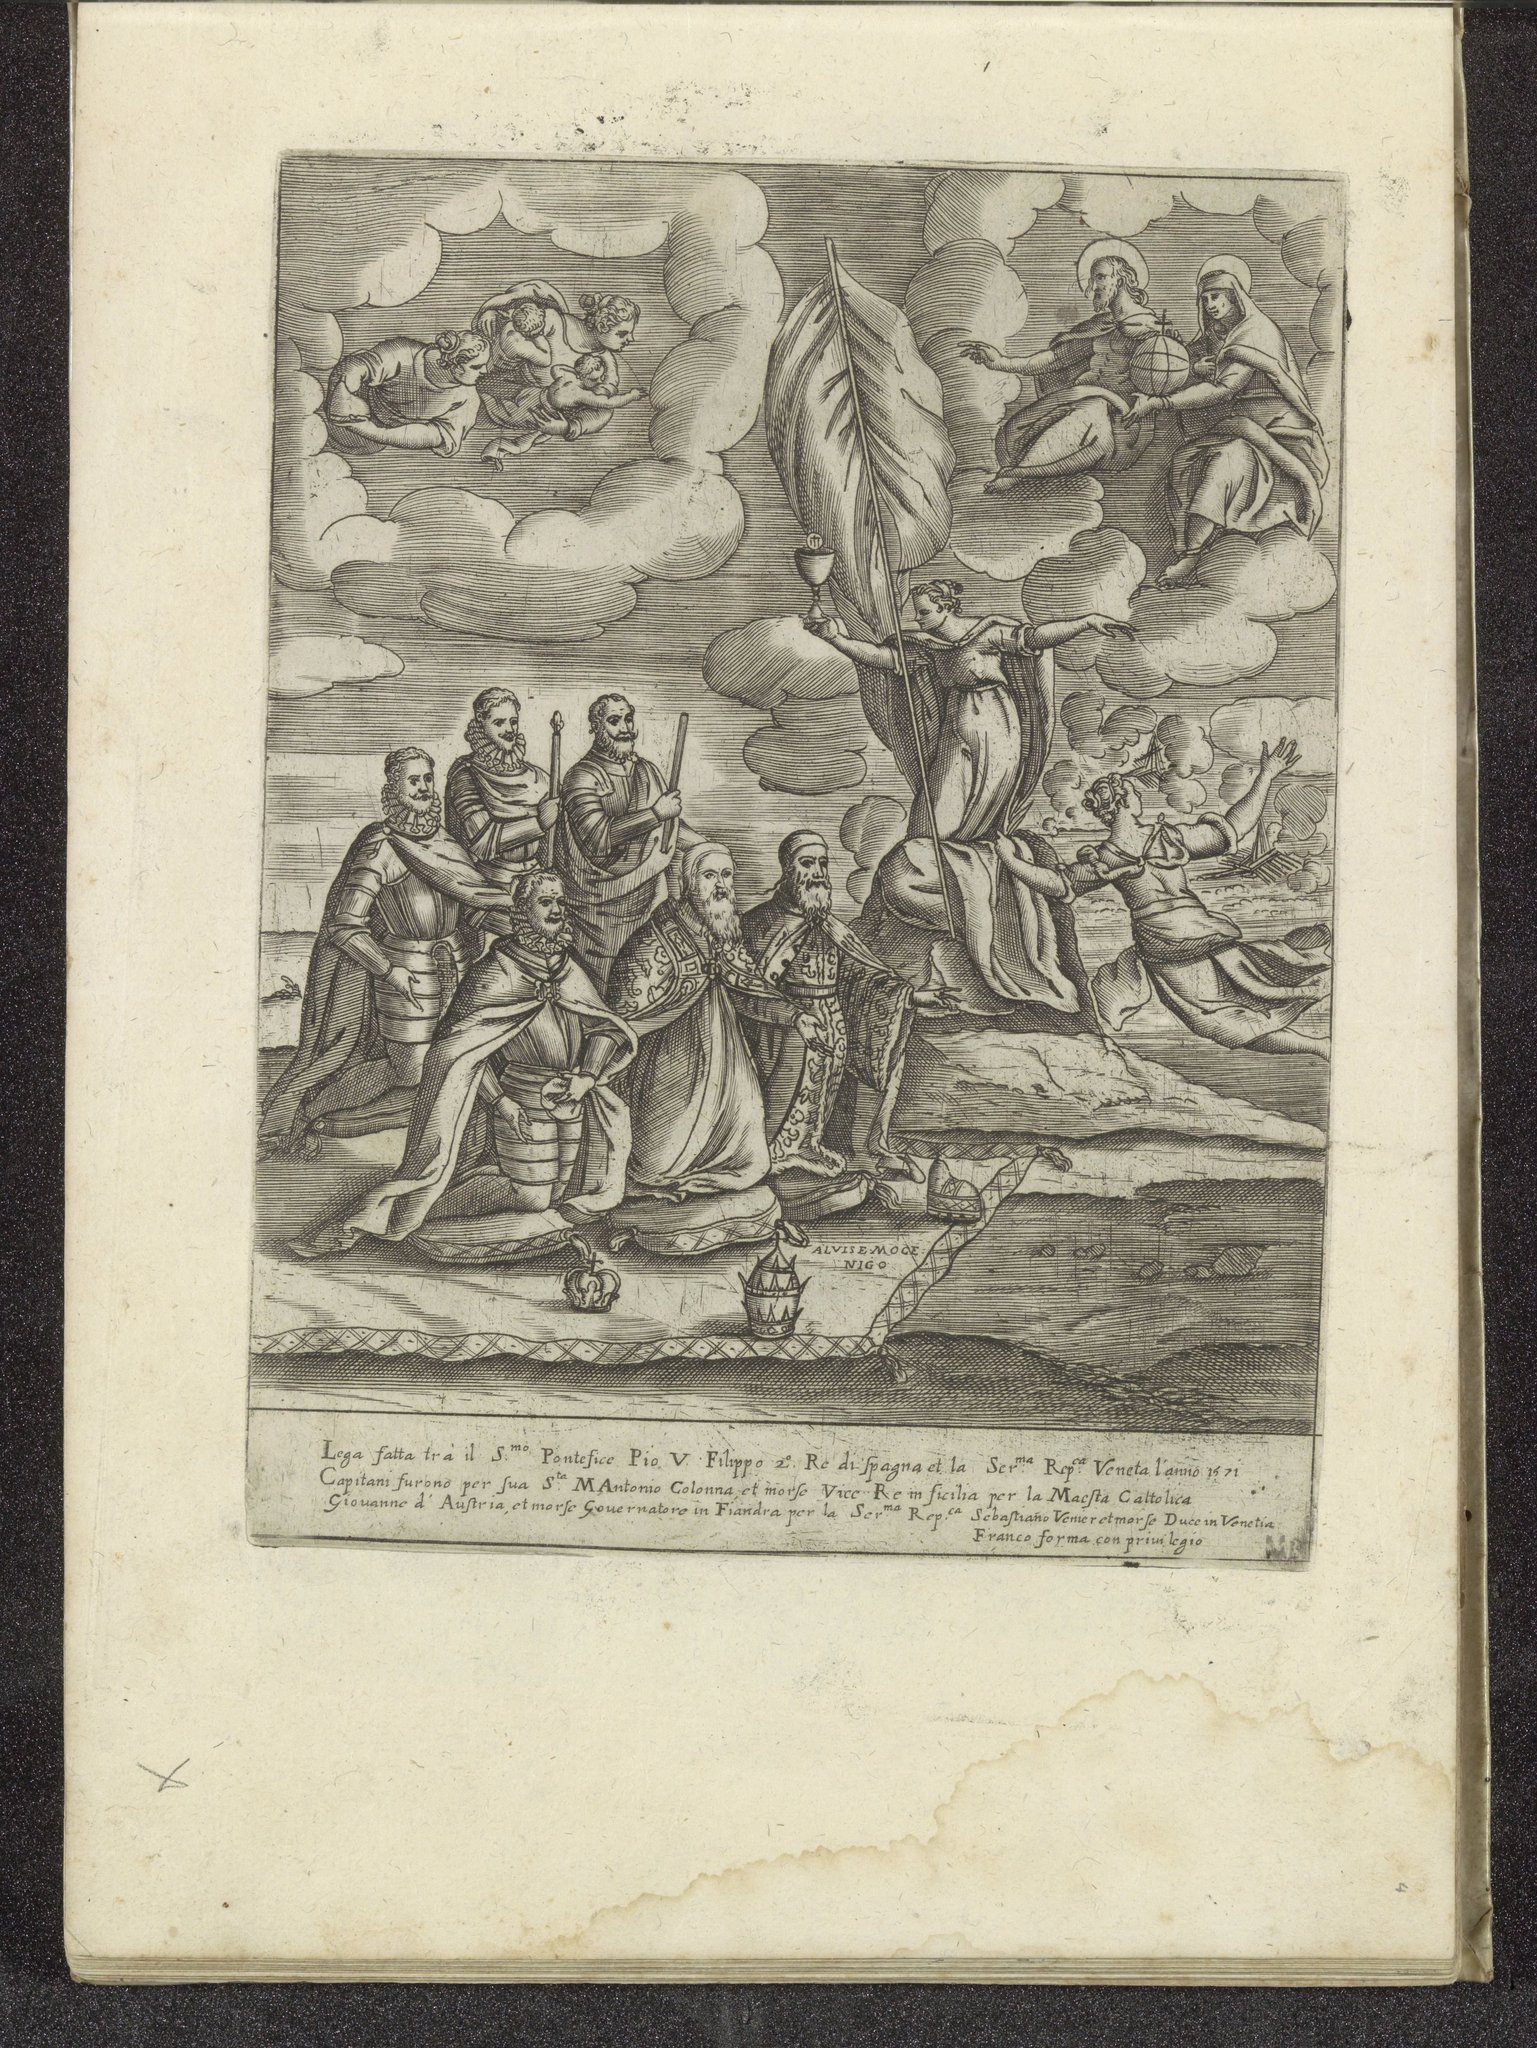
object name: print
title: Scènes uit het Venetiaanse leven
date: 1610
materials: paper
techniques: engraving, intaglio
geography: venice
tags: philip ii of spain, rome, pius v, don juan van oostenrijk, venice, faith, 'fides'; 'fede', 'fede catholica', 'fede christiana', 'fede christiana catholica' (ripa) ~ one of the three theological virtues, battle (+ naval force), pope, commander-in-chief, admiral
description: Rechts een personificatie van het geloof. Links knielen zes figuren die betrokken waren bij de Slag van Lepanto in 1571: paus Pius V, koning Filips II, doge Alvise I Mocenigo, admiraal en later doge Sebastiano Vernier, commandant Marcantonio Colonna en legeraanvoerder Don Juan van Oostenrijk. Drieregelige Italiaanse tekst in ondermarge. De prent maakt deel uit van een album.